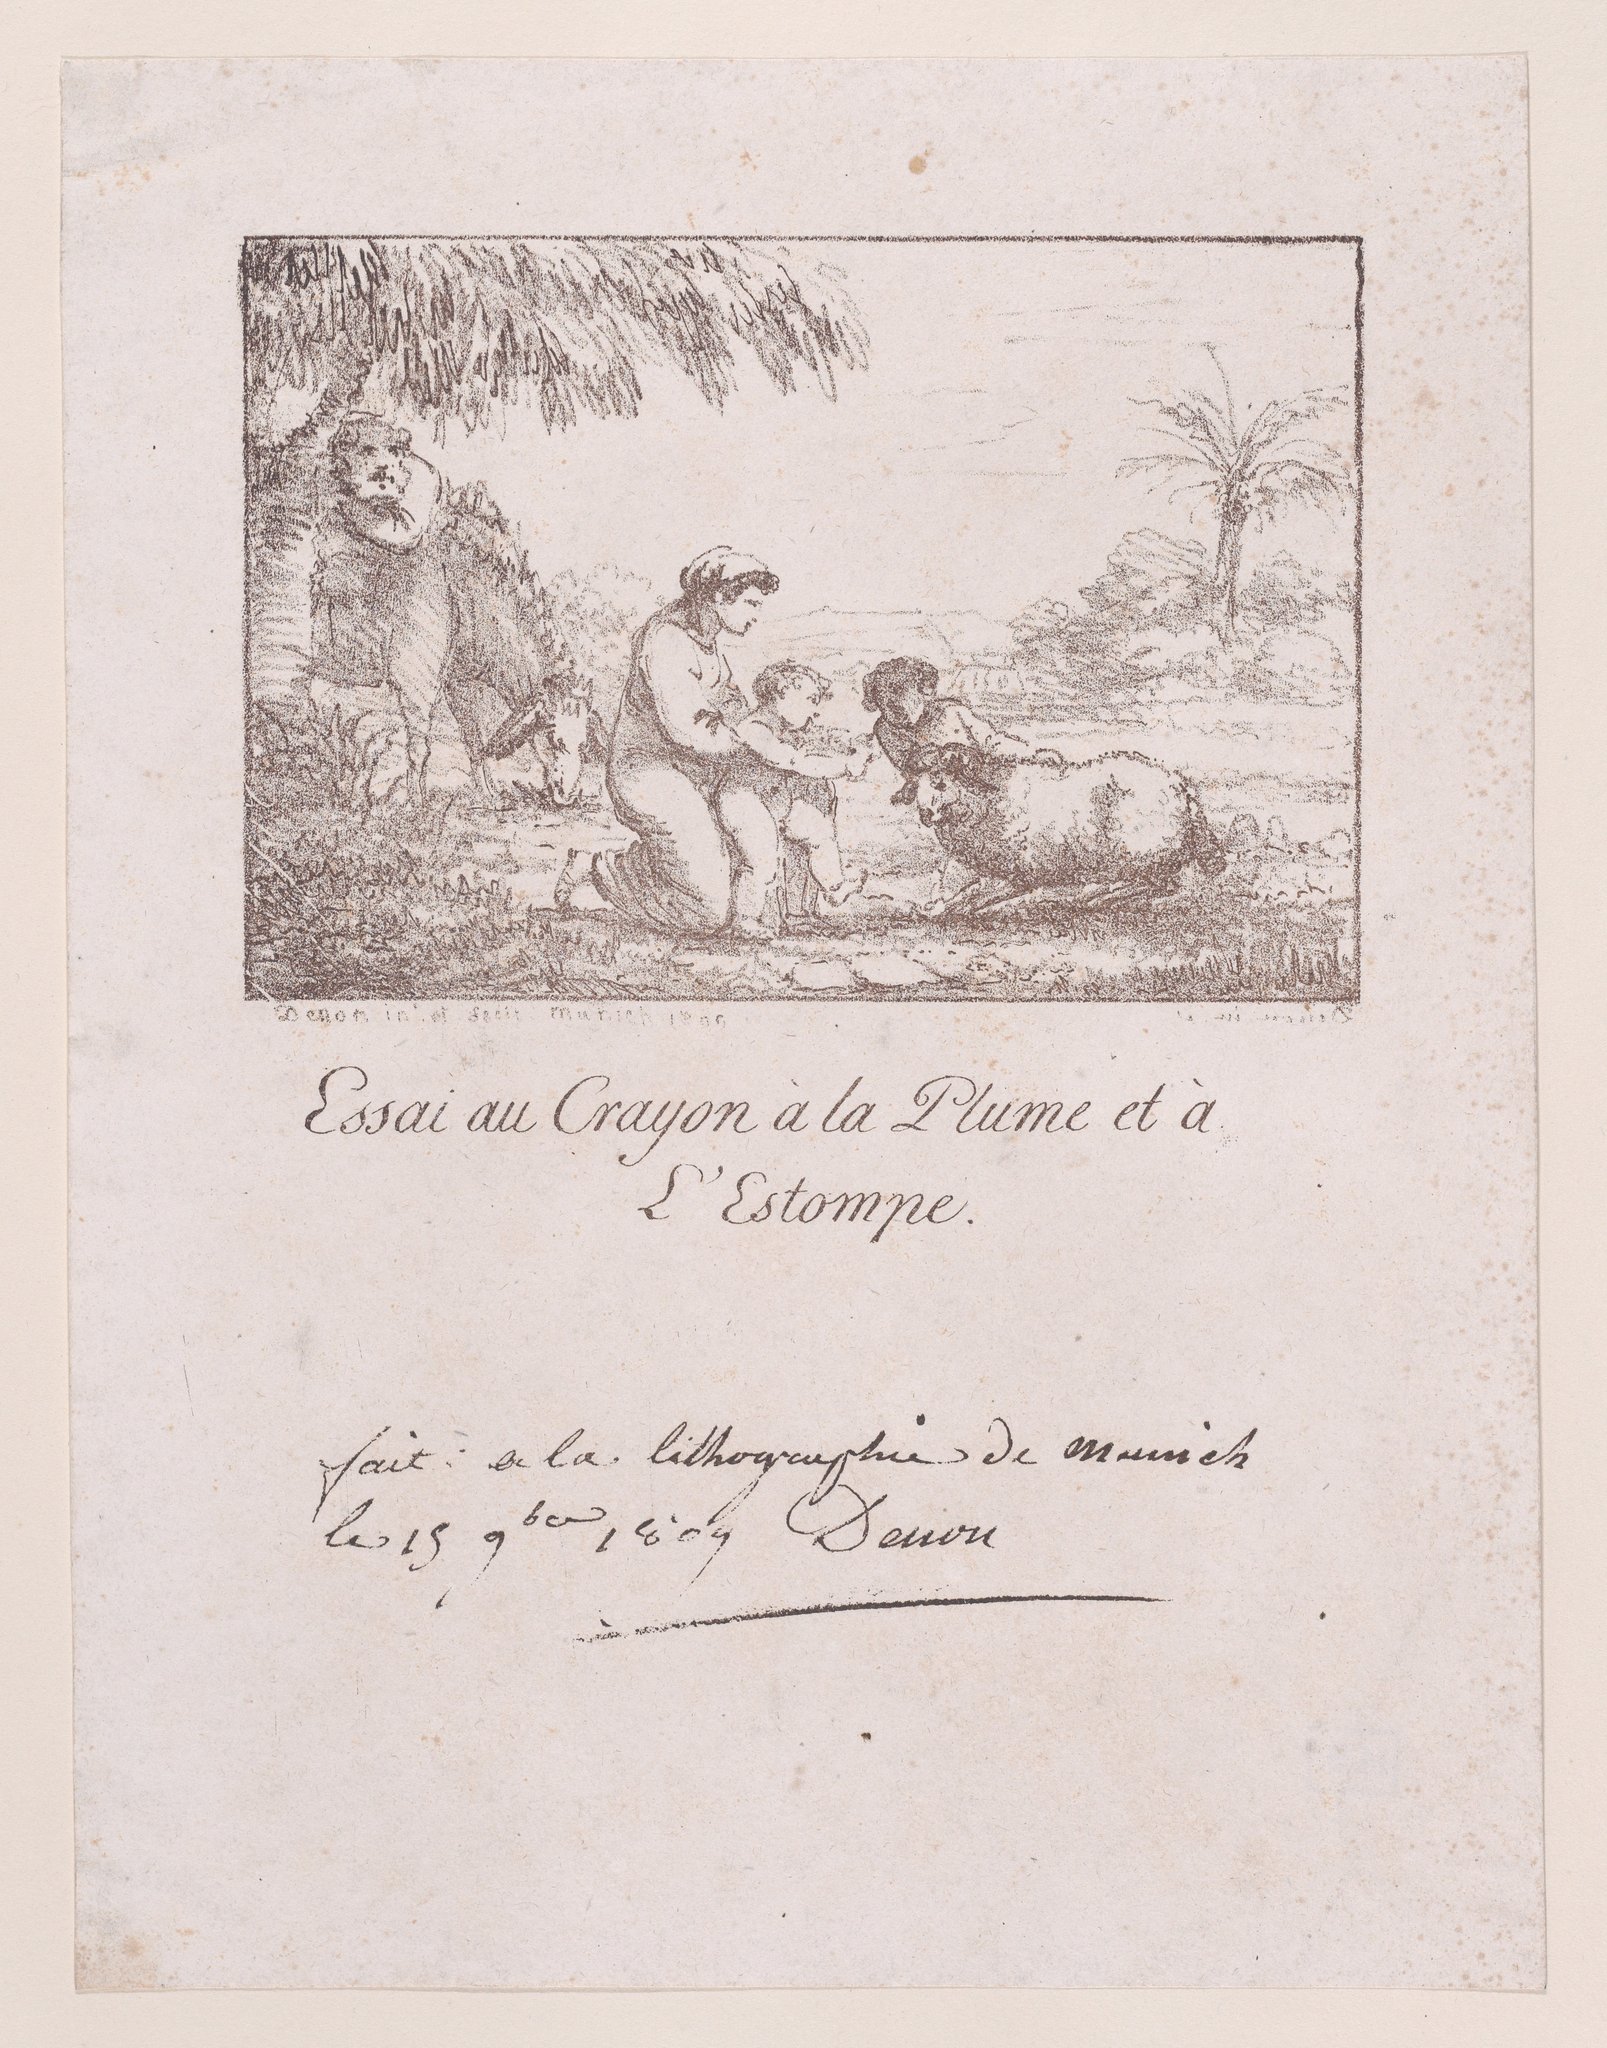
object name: print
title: The Holy Family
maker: baron dominique vivant denon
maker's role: artist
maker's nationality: french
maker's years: 1747-1825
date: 1809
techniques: lithograph